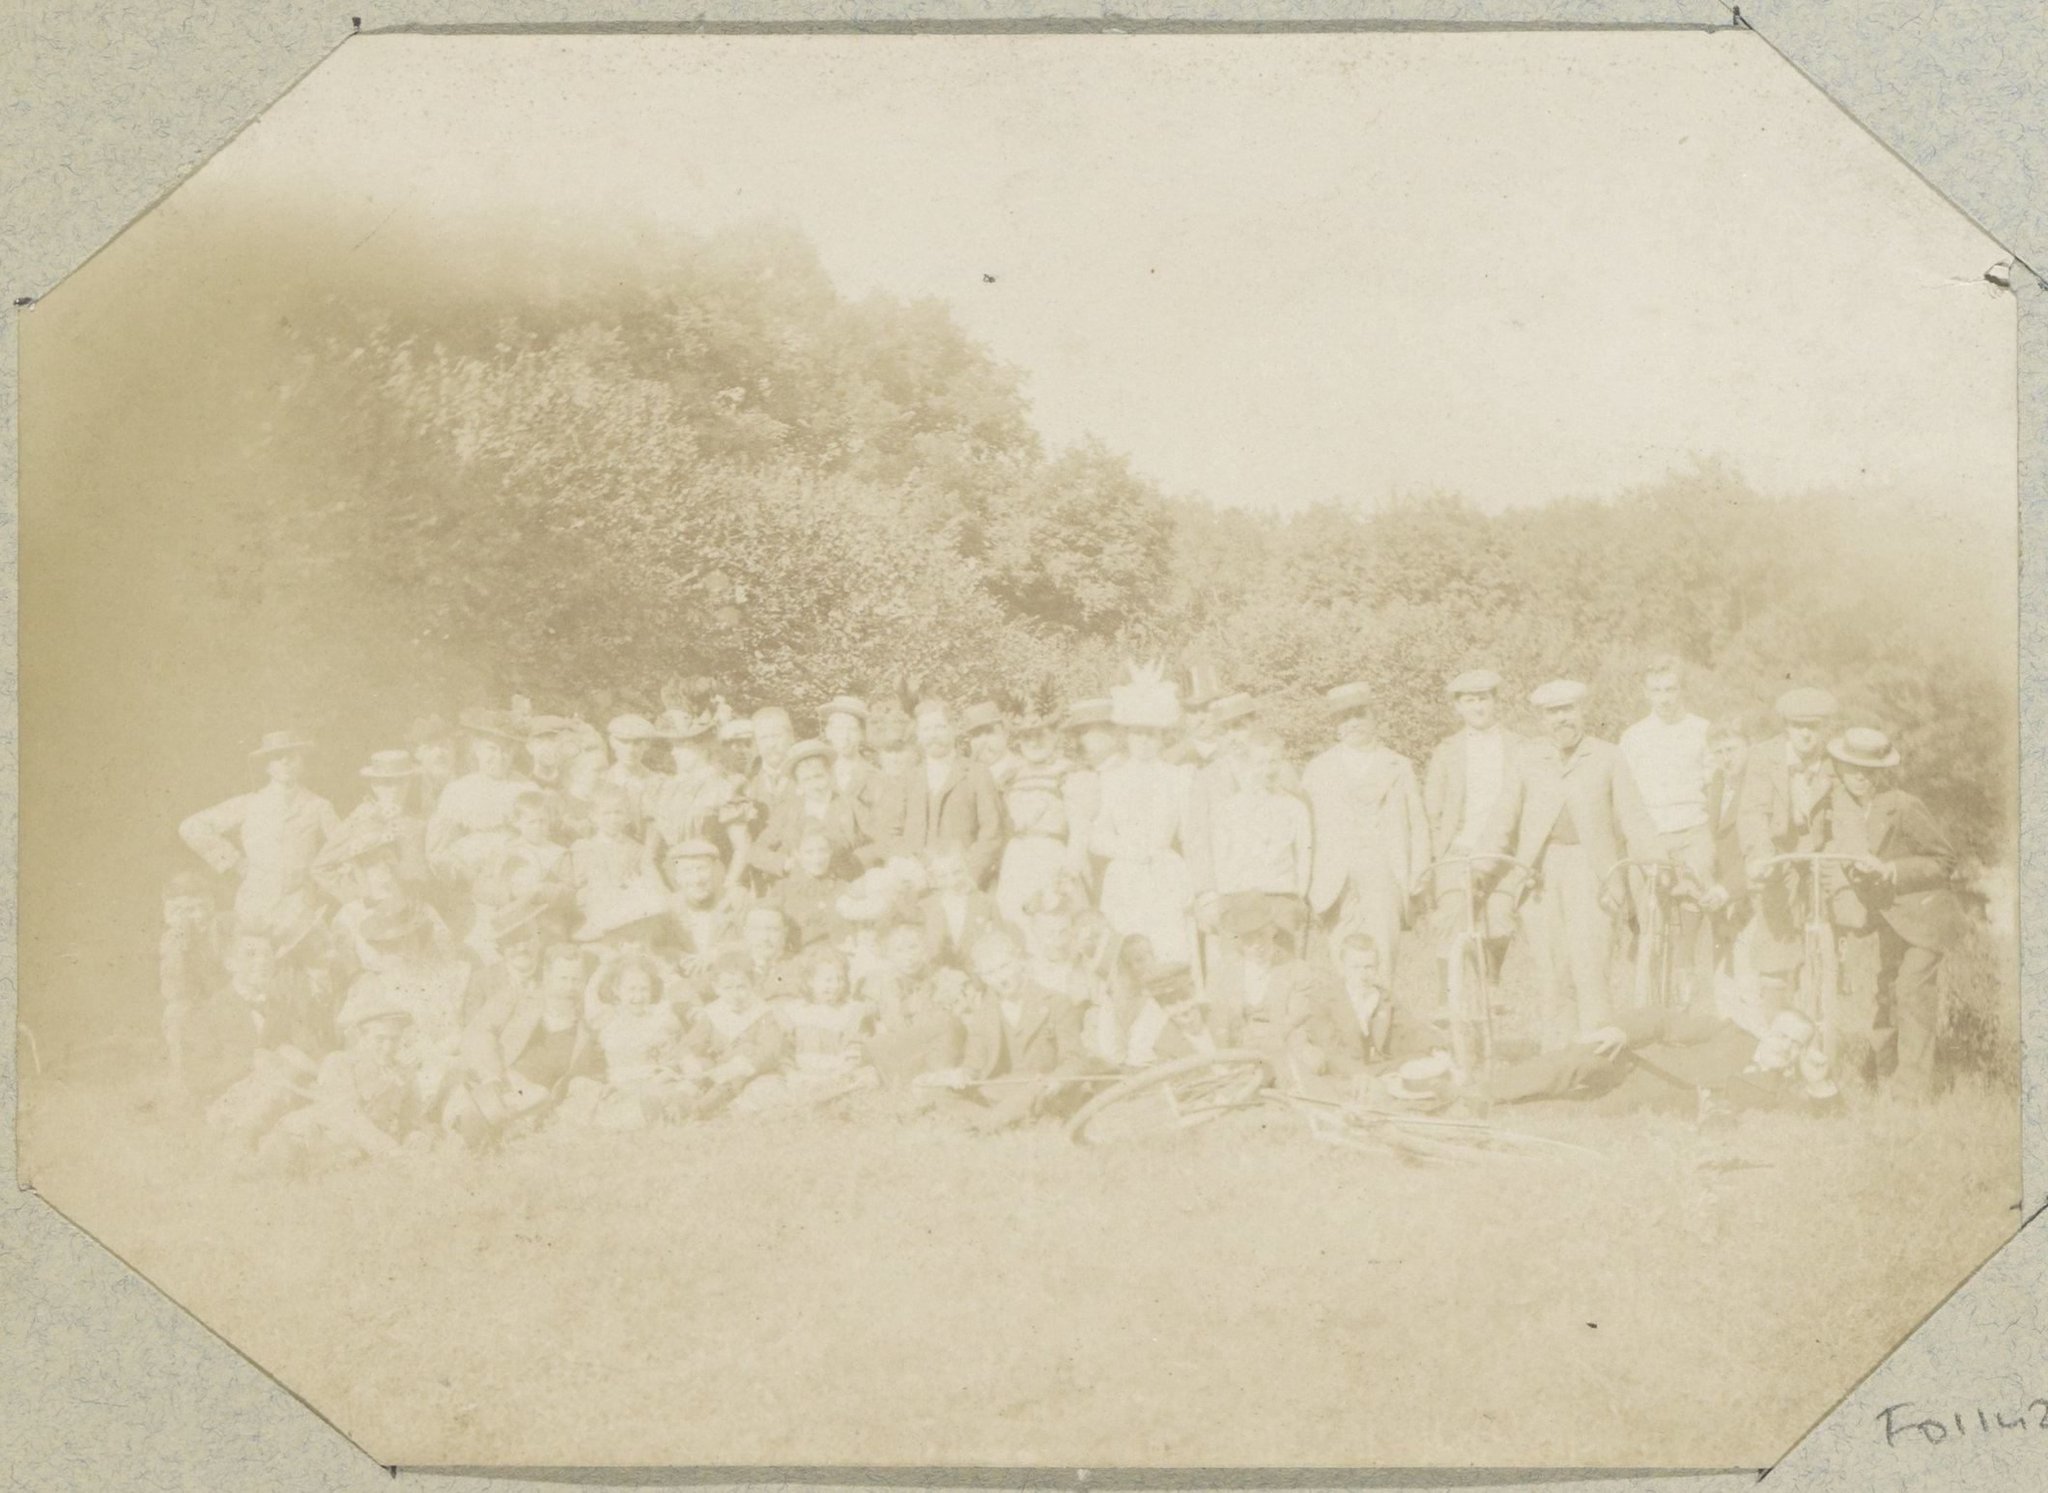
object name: photograph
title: Groepsportret van oud-leerlingen ('l'Association amicale des anciens élèves') tijdens een excursie naar Saint-Germain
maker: Anonymous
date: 1880-1900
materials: paper, photographic support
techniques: salted paper print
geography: france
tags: outing, pleasure trip, bicycle, france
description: Onderdeel van Album van een Franse amateur met foto's van Frankrijk, Algerije, Palmyra, de Wereldtentoonstelling van 1900 en van bekende Fransen.